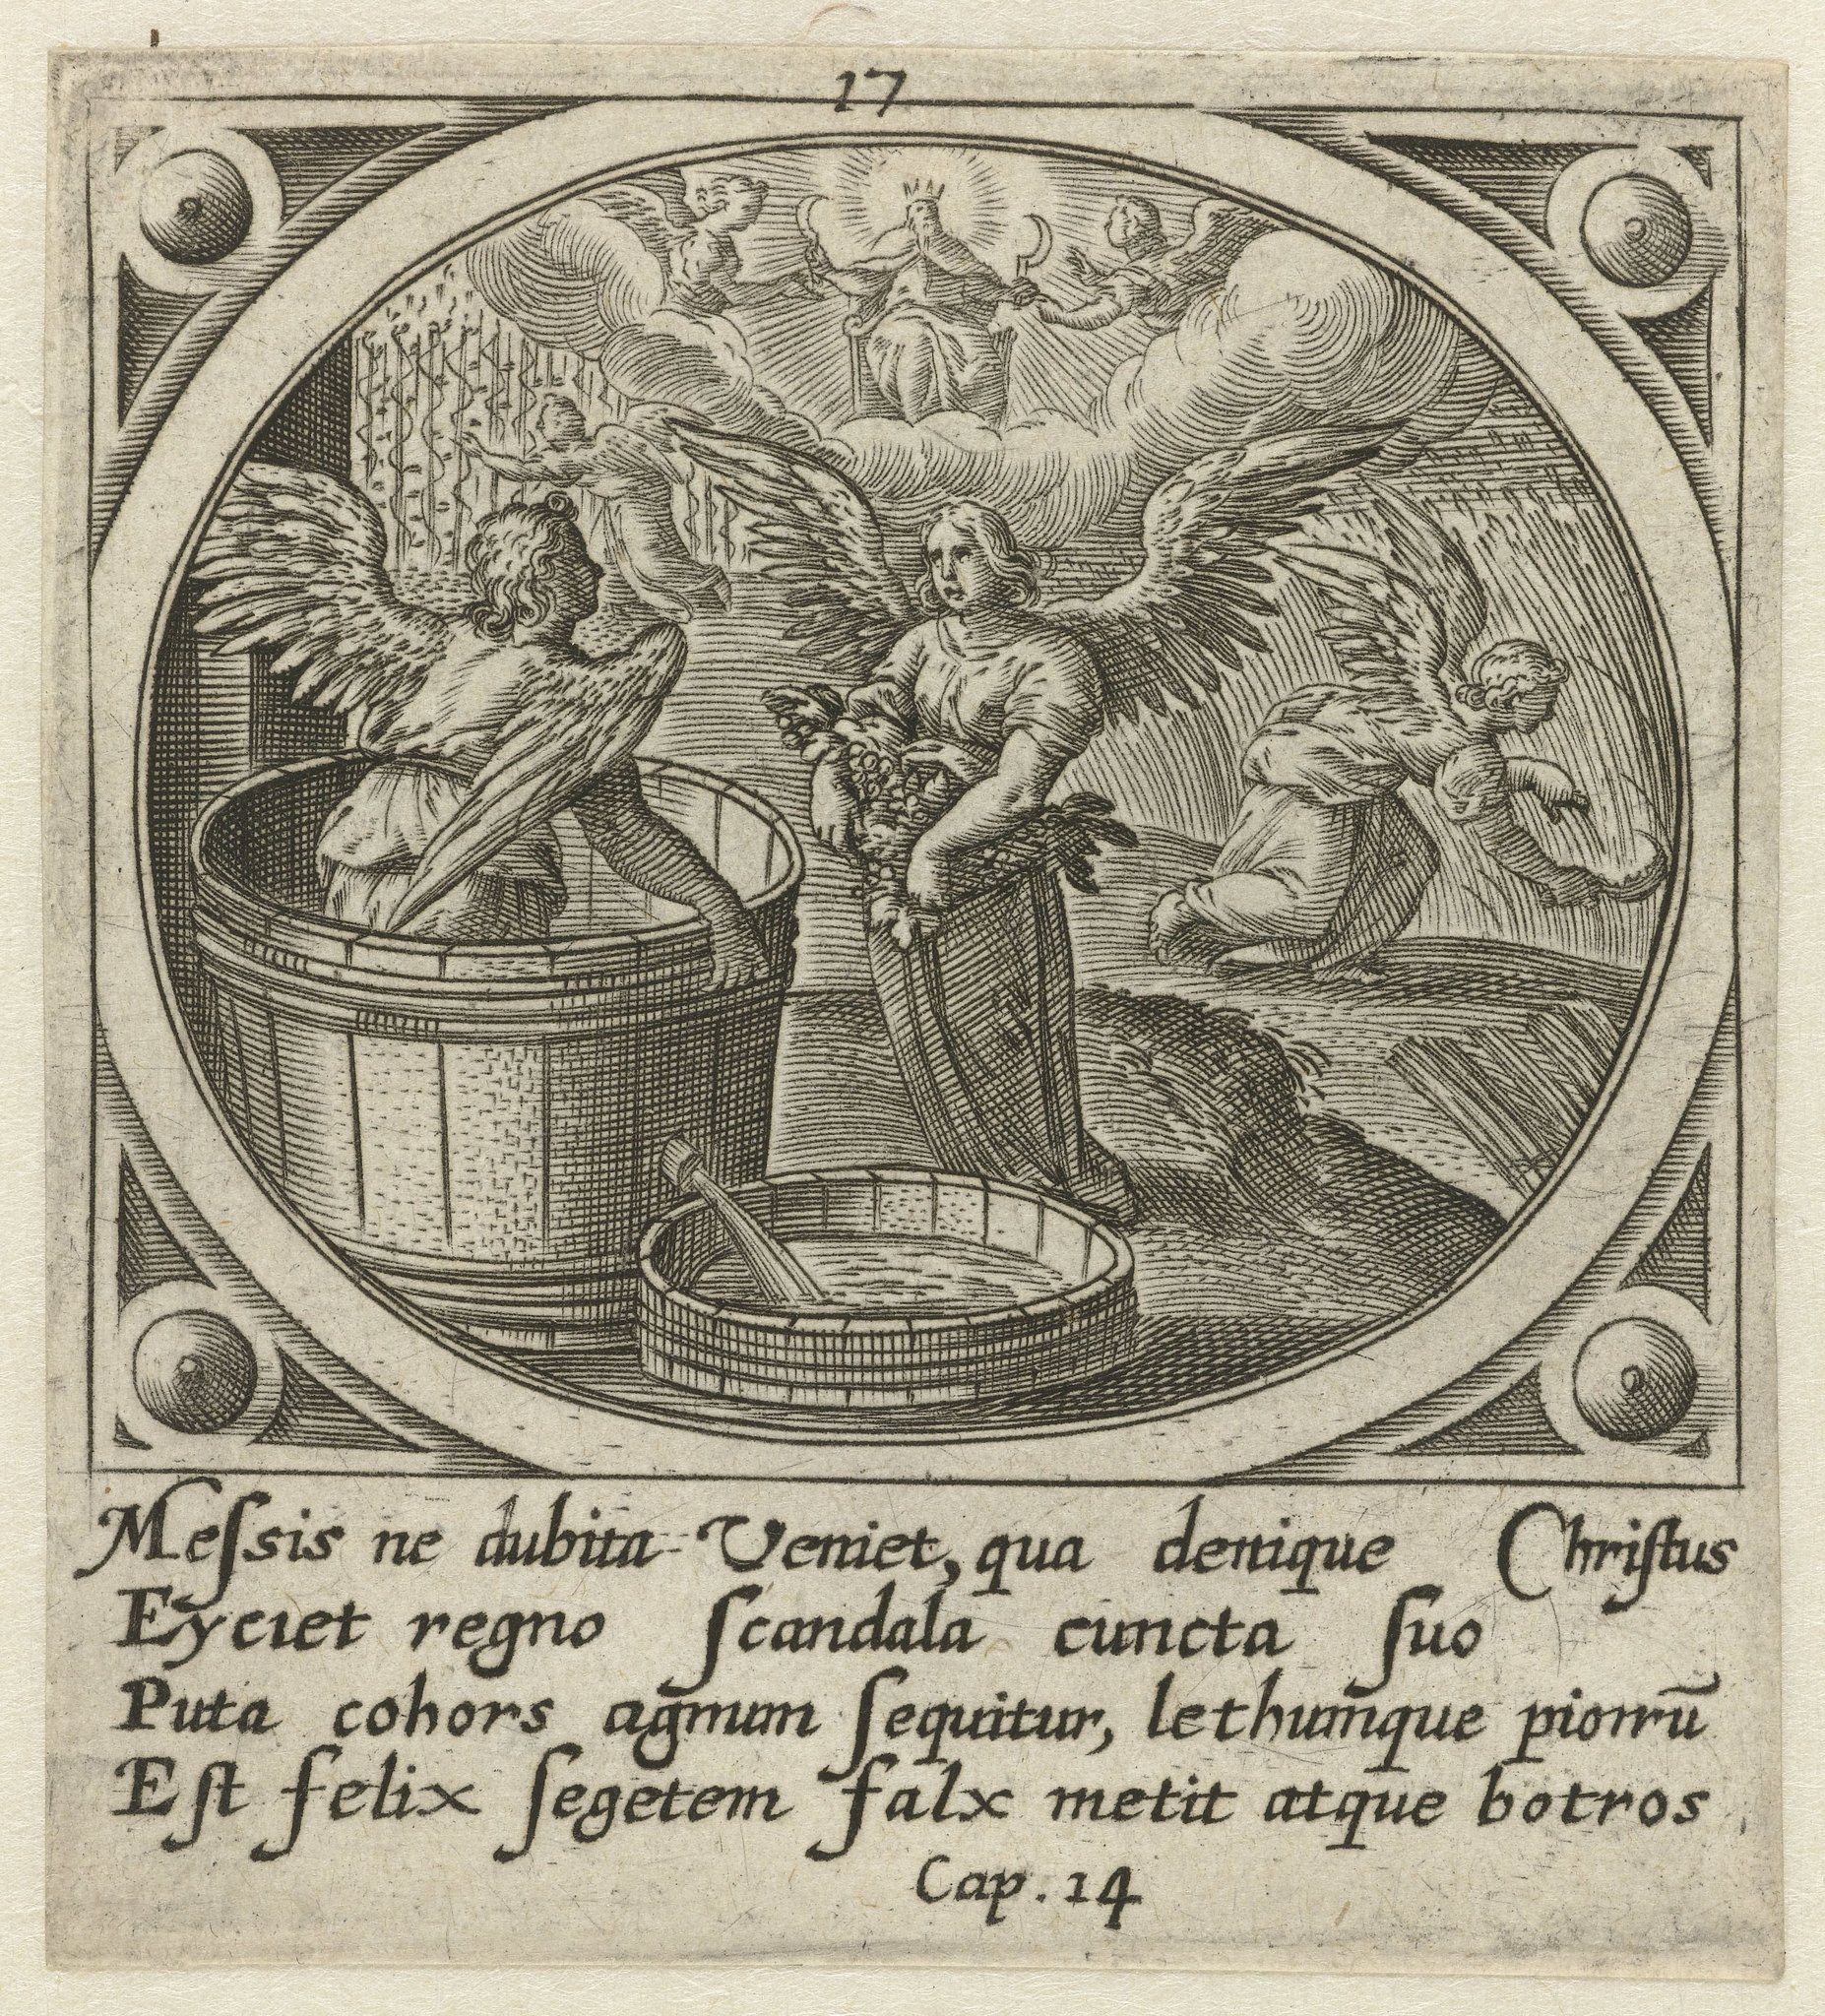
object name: print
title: Oogsten met sikkel en wijnpers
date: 1585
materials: paper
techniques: engraving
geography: antwerp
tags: an angel thrusts his sickle into the earth, and gathers the vine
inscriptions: collector's mark: Lugt 2228, collector's mark: Lugt 2760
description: Vier engelen oogsten druiven en graan met een sikkel en gooien druiven in een wijnpers. In de wolken een gekroonde figuur met sikkel in de hand, zittend op een troon, geflankeerd door twee engelen. In de marge een vierregelig onderschrift in het Latijn. Zeventiende prent uit een serie van vierentwintig met de openbaring van Johannes op Patmos.